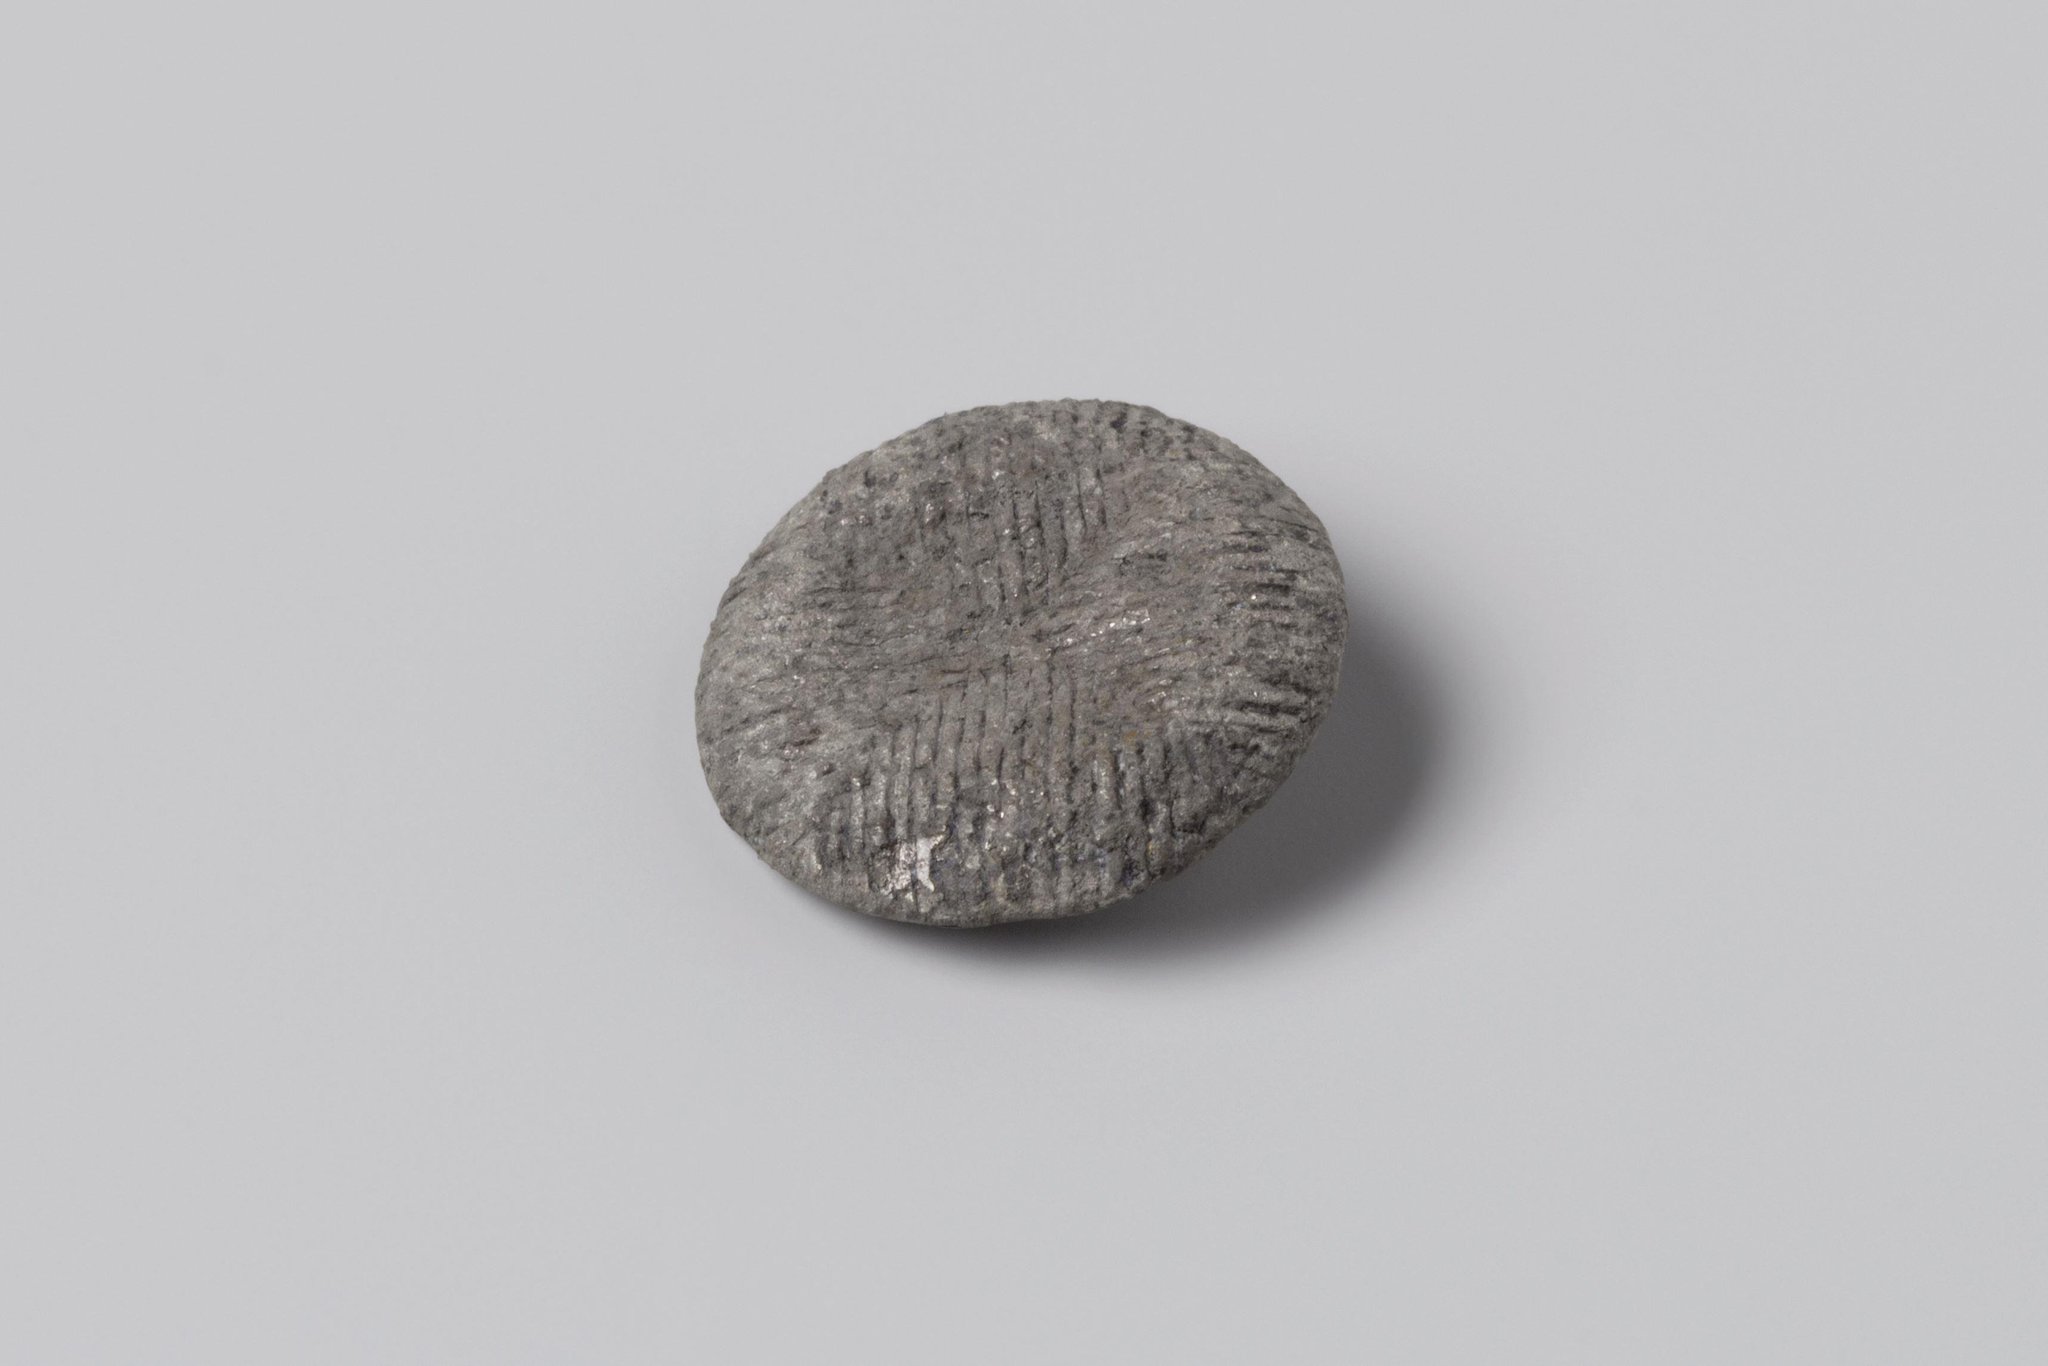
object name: button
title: Knoop uit het wrak van de Oost-Indiëvaarder Hollandia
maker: Anonymous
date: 1700-1743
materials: tin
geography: netherlands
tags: verenigde oostindische compagnie, hollandia (schip), annet